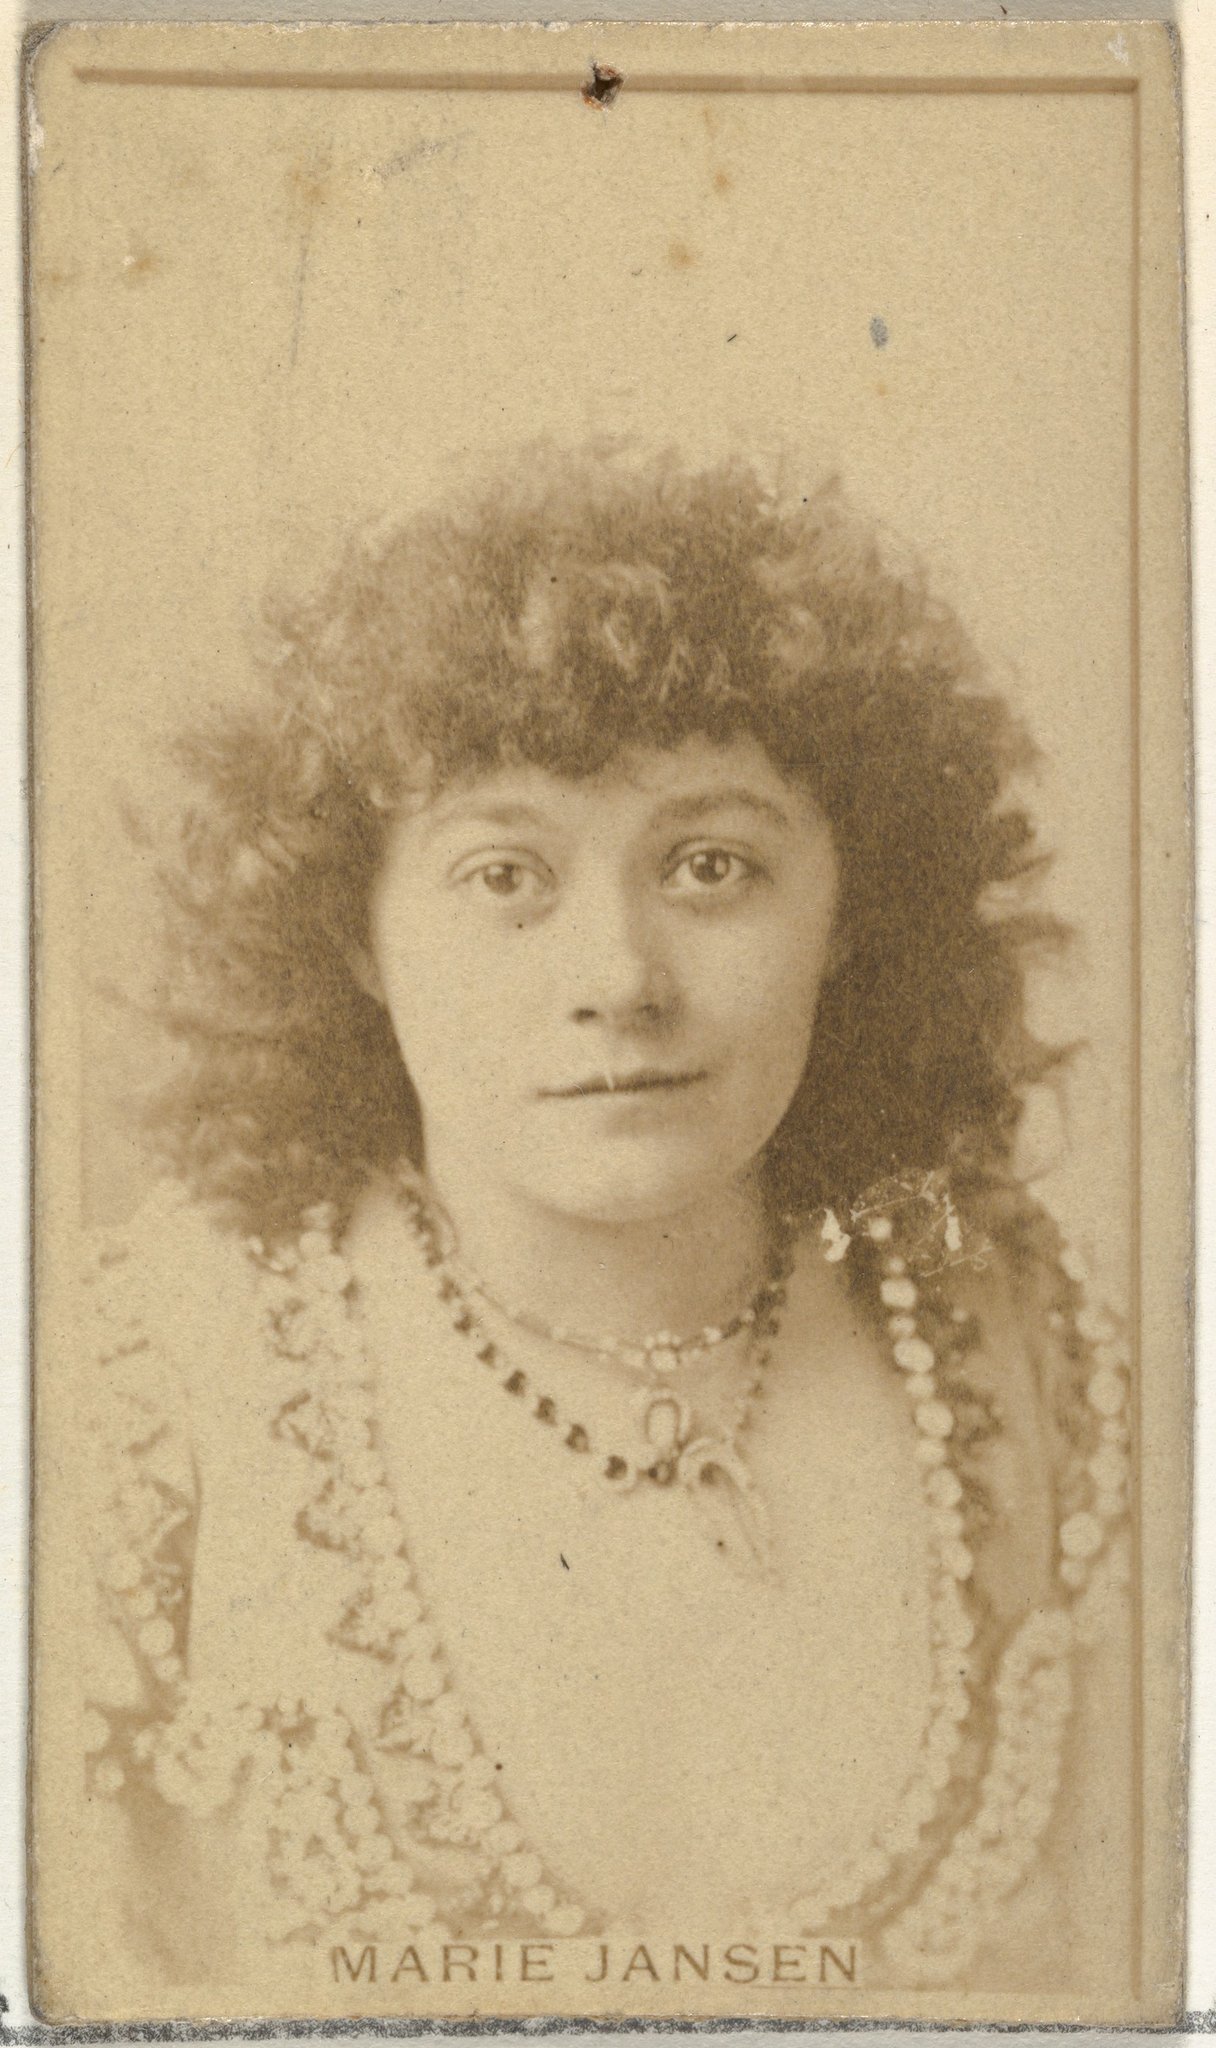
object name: photograph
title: Marie Jansen, from the Actors and Actresses series (N145-8) issued by Duke Sons & Co. to promote Duke Cigarettes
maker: w. duke, sons & co.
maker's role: publisher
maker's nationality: american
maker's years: 1870-1920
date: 1891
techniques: albumen silver print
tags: portraits,women,actresses